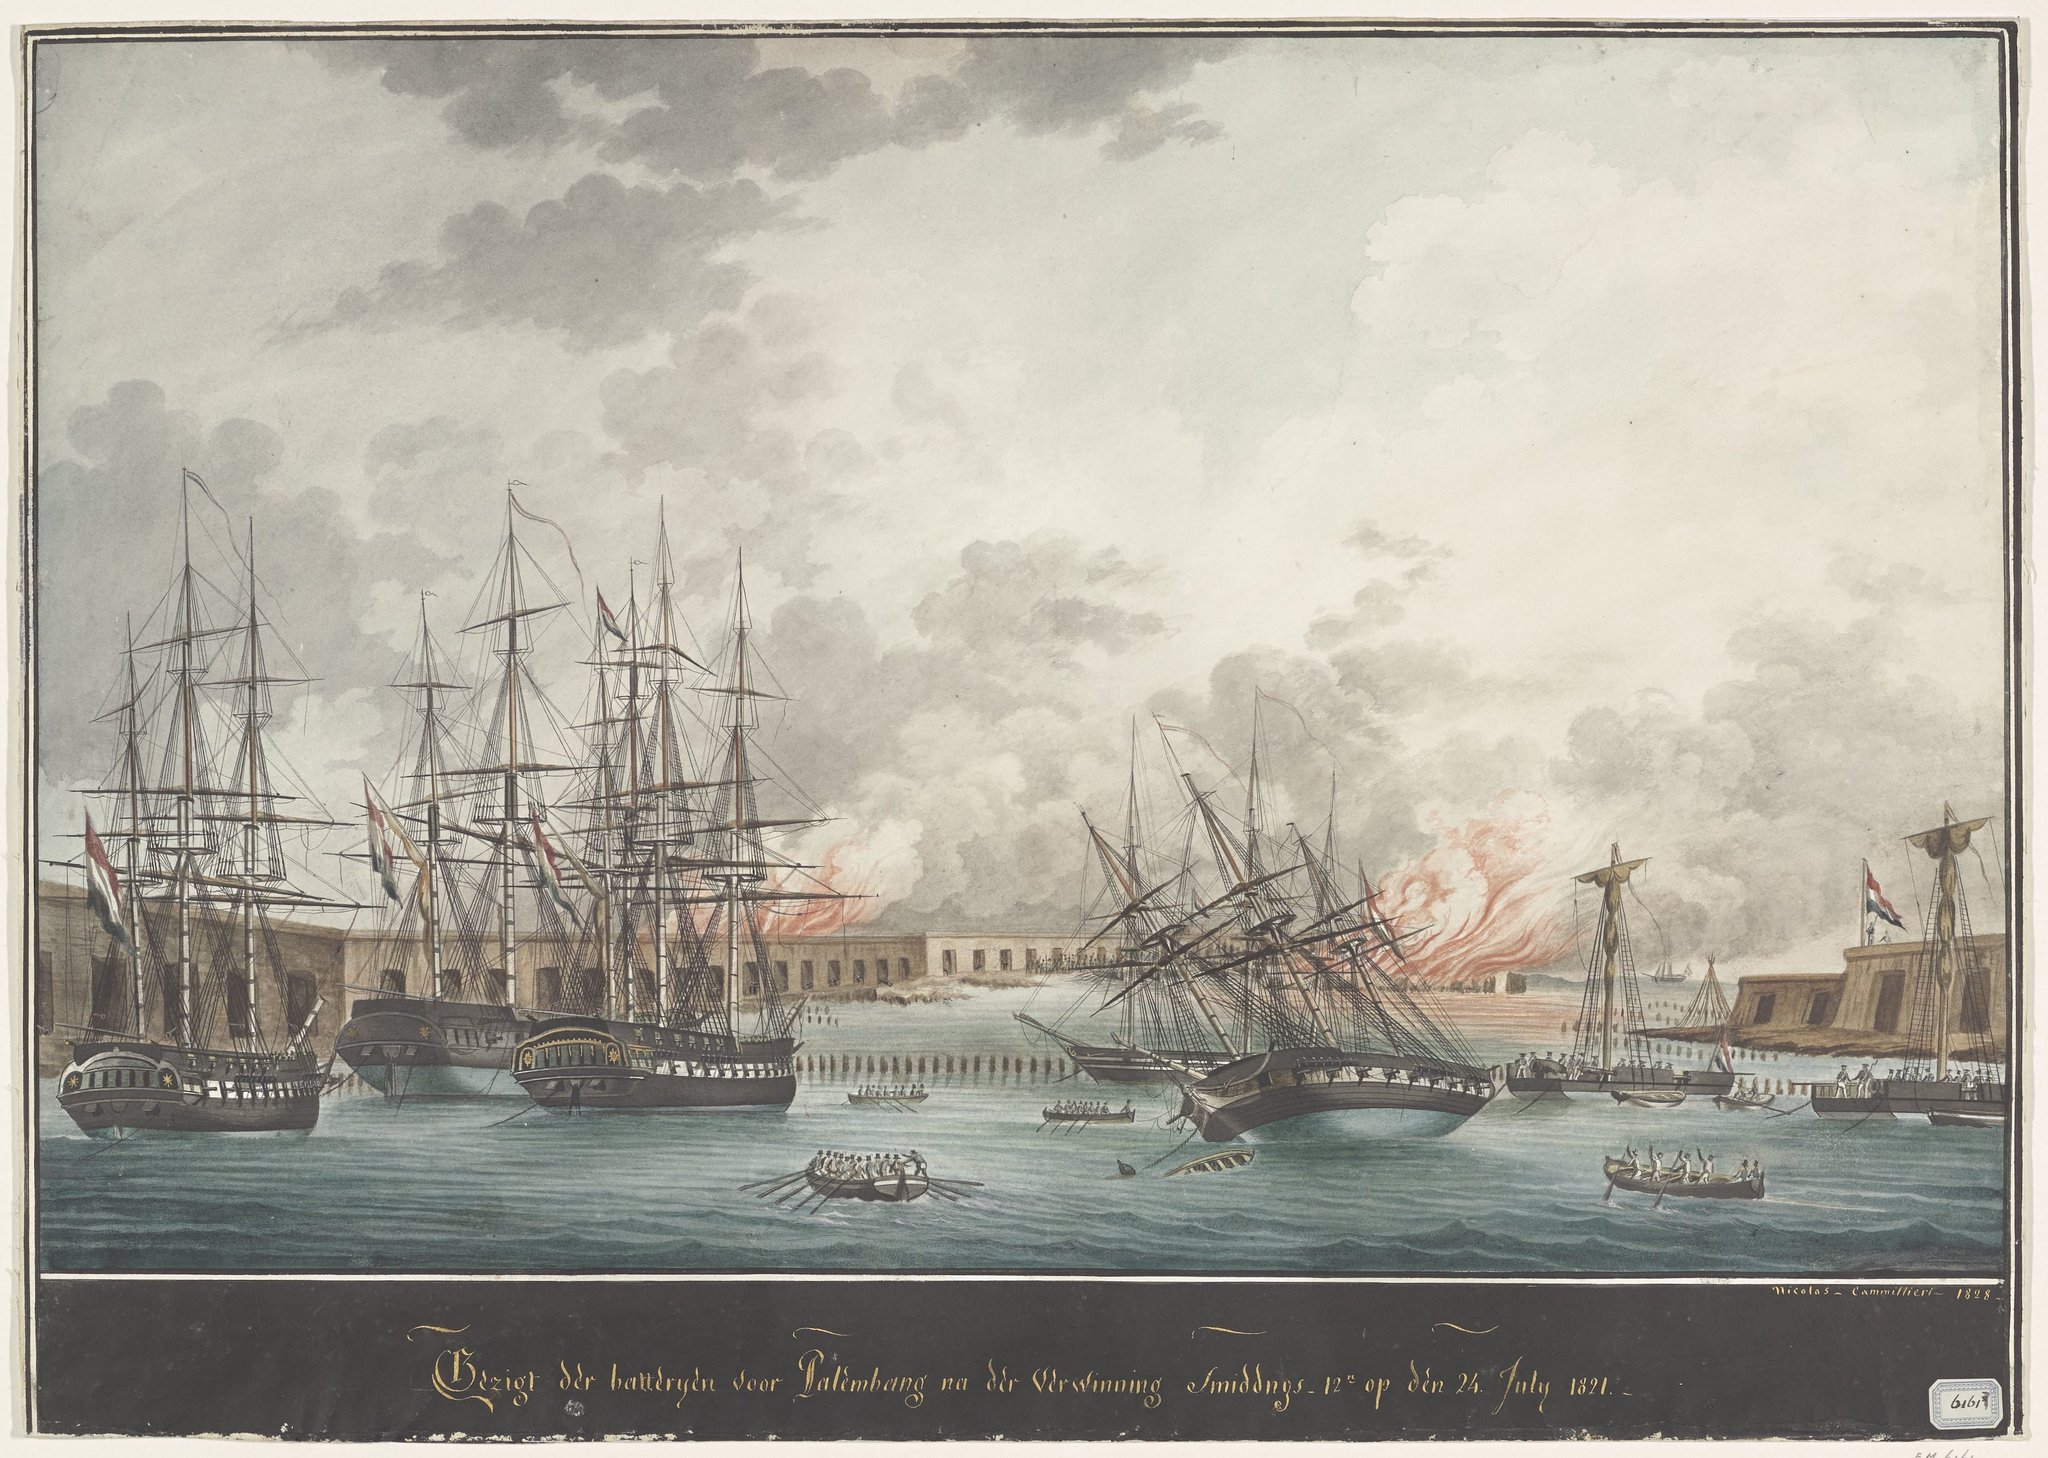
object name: history print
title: Gezigt der batterijen voor Palembang na der Verwinning smiddags - 12u. op den 24. July 1821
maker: nicolas cammillieri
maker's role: draughtsman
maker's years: 1762-1860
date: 1828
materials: paper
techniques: brush, pen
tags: bombardment ~ siege (+ sailing-ships)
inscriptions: collector's mark: Lugt 2228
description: Beschieting van de kustbatterijen gelegen aan de rivier in Palembang op Sumatra door Nederlandse oorlogsschepen onder bevel van generaal H.M. de Kock tijdens de Tweede expeditie naar Palembang, 24 juni 1821. Verschillende Nederlandse oorlogsschepen liggen voor anker, centraal een kapseisend schip.